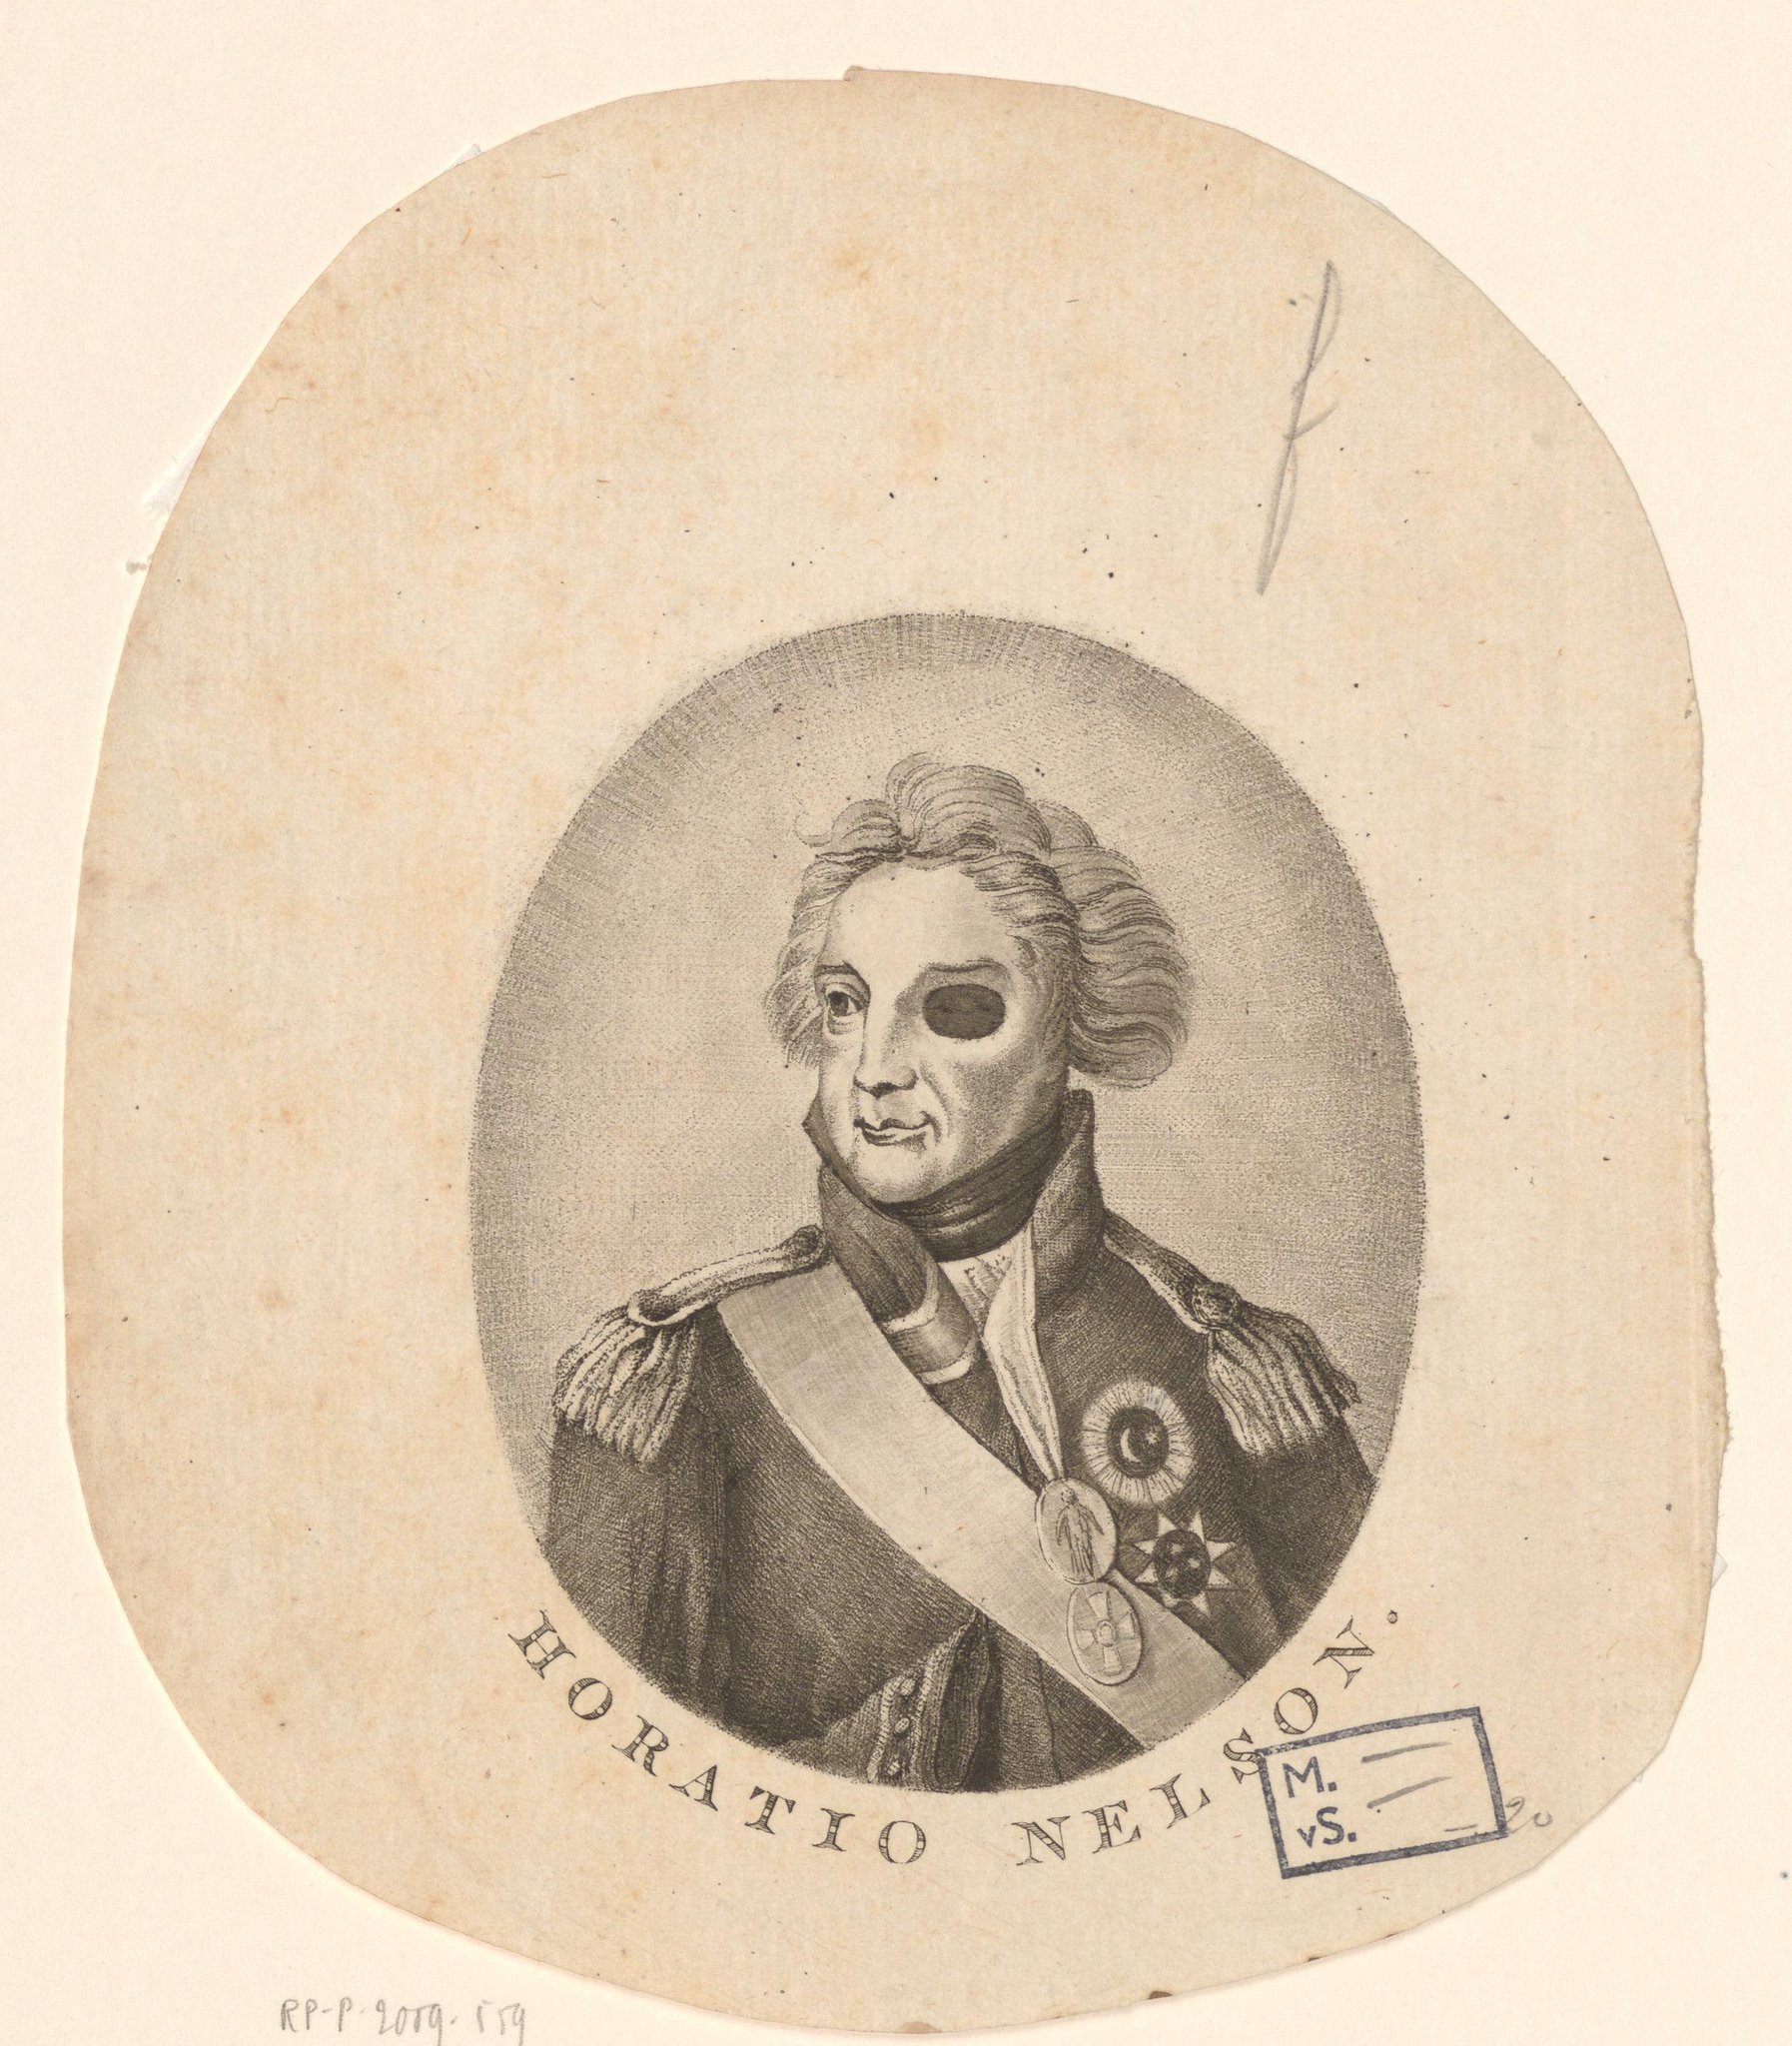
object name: print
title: Portret van Horatio Nelson, hertog van Bronte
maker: Anonymous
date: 1797-1849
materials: paper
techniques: etching, intaglio, roulette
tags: horatio nelson (hertog van bronte), historical persons, commander-in-chief, admiral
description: Portret van Horatio Nelson in uniform met onderscheidingen, staand naar links en leunend tegen een rots. Links de zee met in de verte schepen. In de lucht zware bewolking. Om de voorstelling heen omlijsting van zeilen en vaarbenodigdheden (waaronder anker, kompas en kanon). Onderaan, onder het kompas, zijn naam.